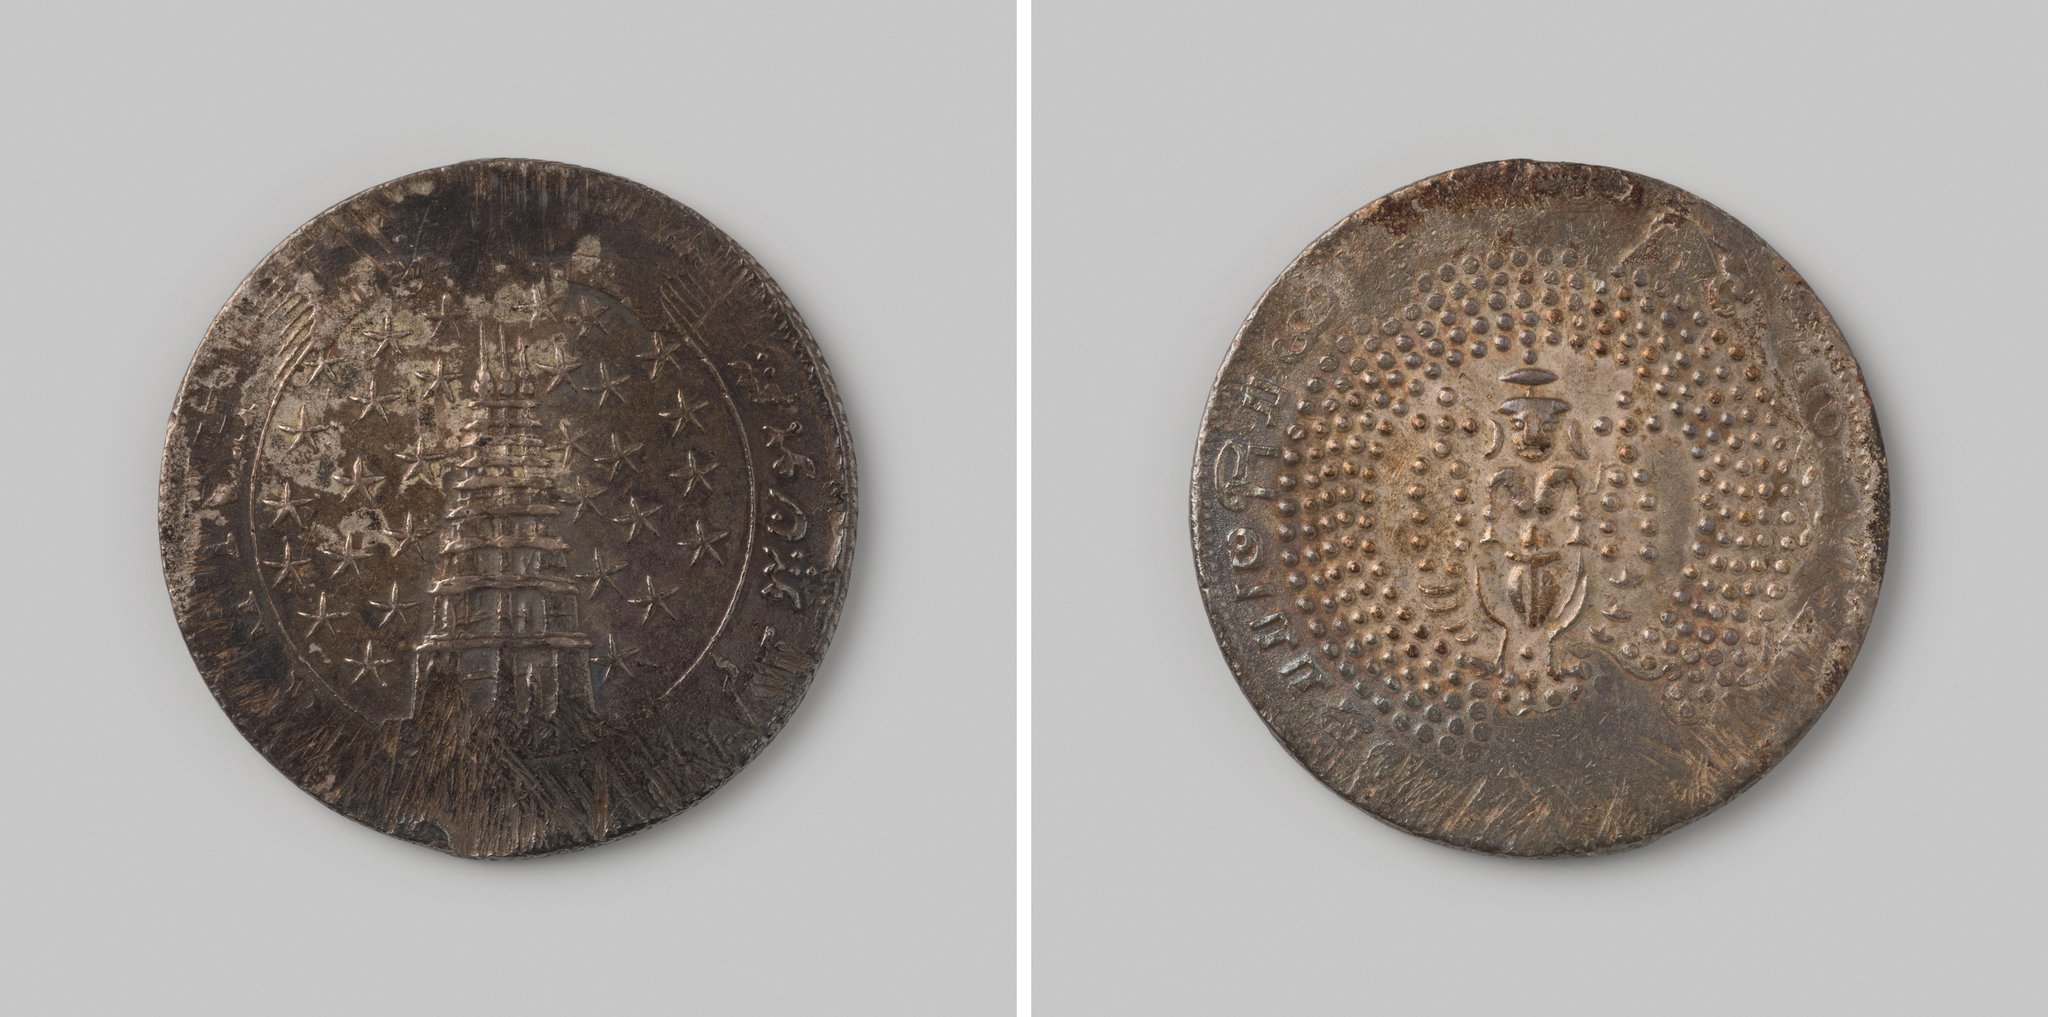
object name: coin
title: ½ pagodae voor Madras in India van de Engelse Oostindische Compagnie (EIC), (1807)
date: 1807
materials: silver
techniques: striking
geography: chennai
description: Zilveren munt. Voorzijde: binnen cirkel, gevormd door lint, waarop waarde-aanduiding in het Engels: half pagoda, en in Arabische lettertekens, tempelpoort, waaromheen sterren. Bovenaan, tussen uiteinden van het lint, een ster. Keerzijde: binnen brede rand, waarop waarde-aanduiding in het Tamil en in het Telugu, godheid ten halve lijve, staande, in een veld, bezaaid met korrels. Kabelrand. Waarde-aanduidingen op munt zijn gedeeltelijk weggevijld, wellicht omdat munt vermoedelijk is overgeslagen op een pillardollar.